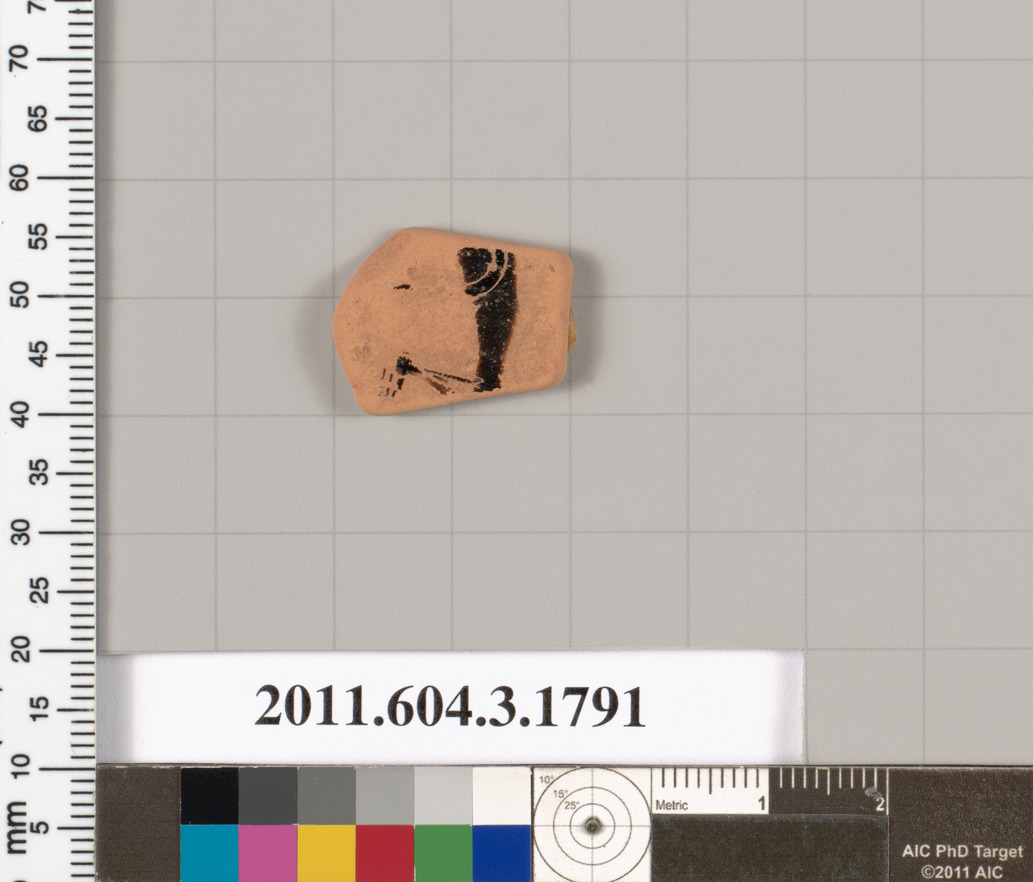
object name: kylix fragment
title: Terracotta fragment of a kylix: Lip cup (drinking cup)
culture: greek, attic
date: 550-526 BCE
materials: terracotta